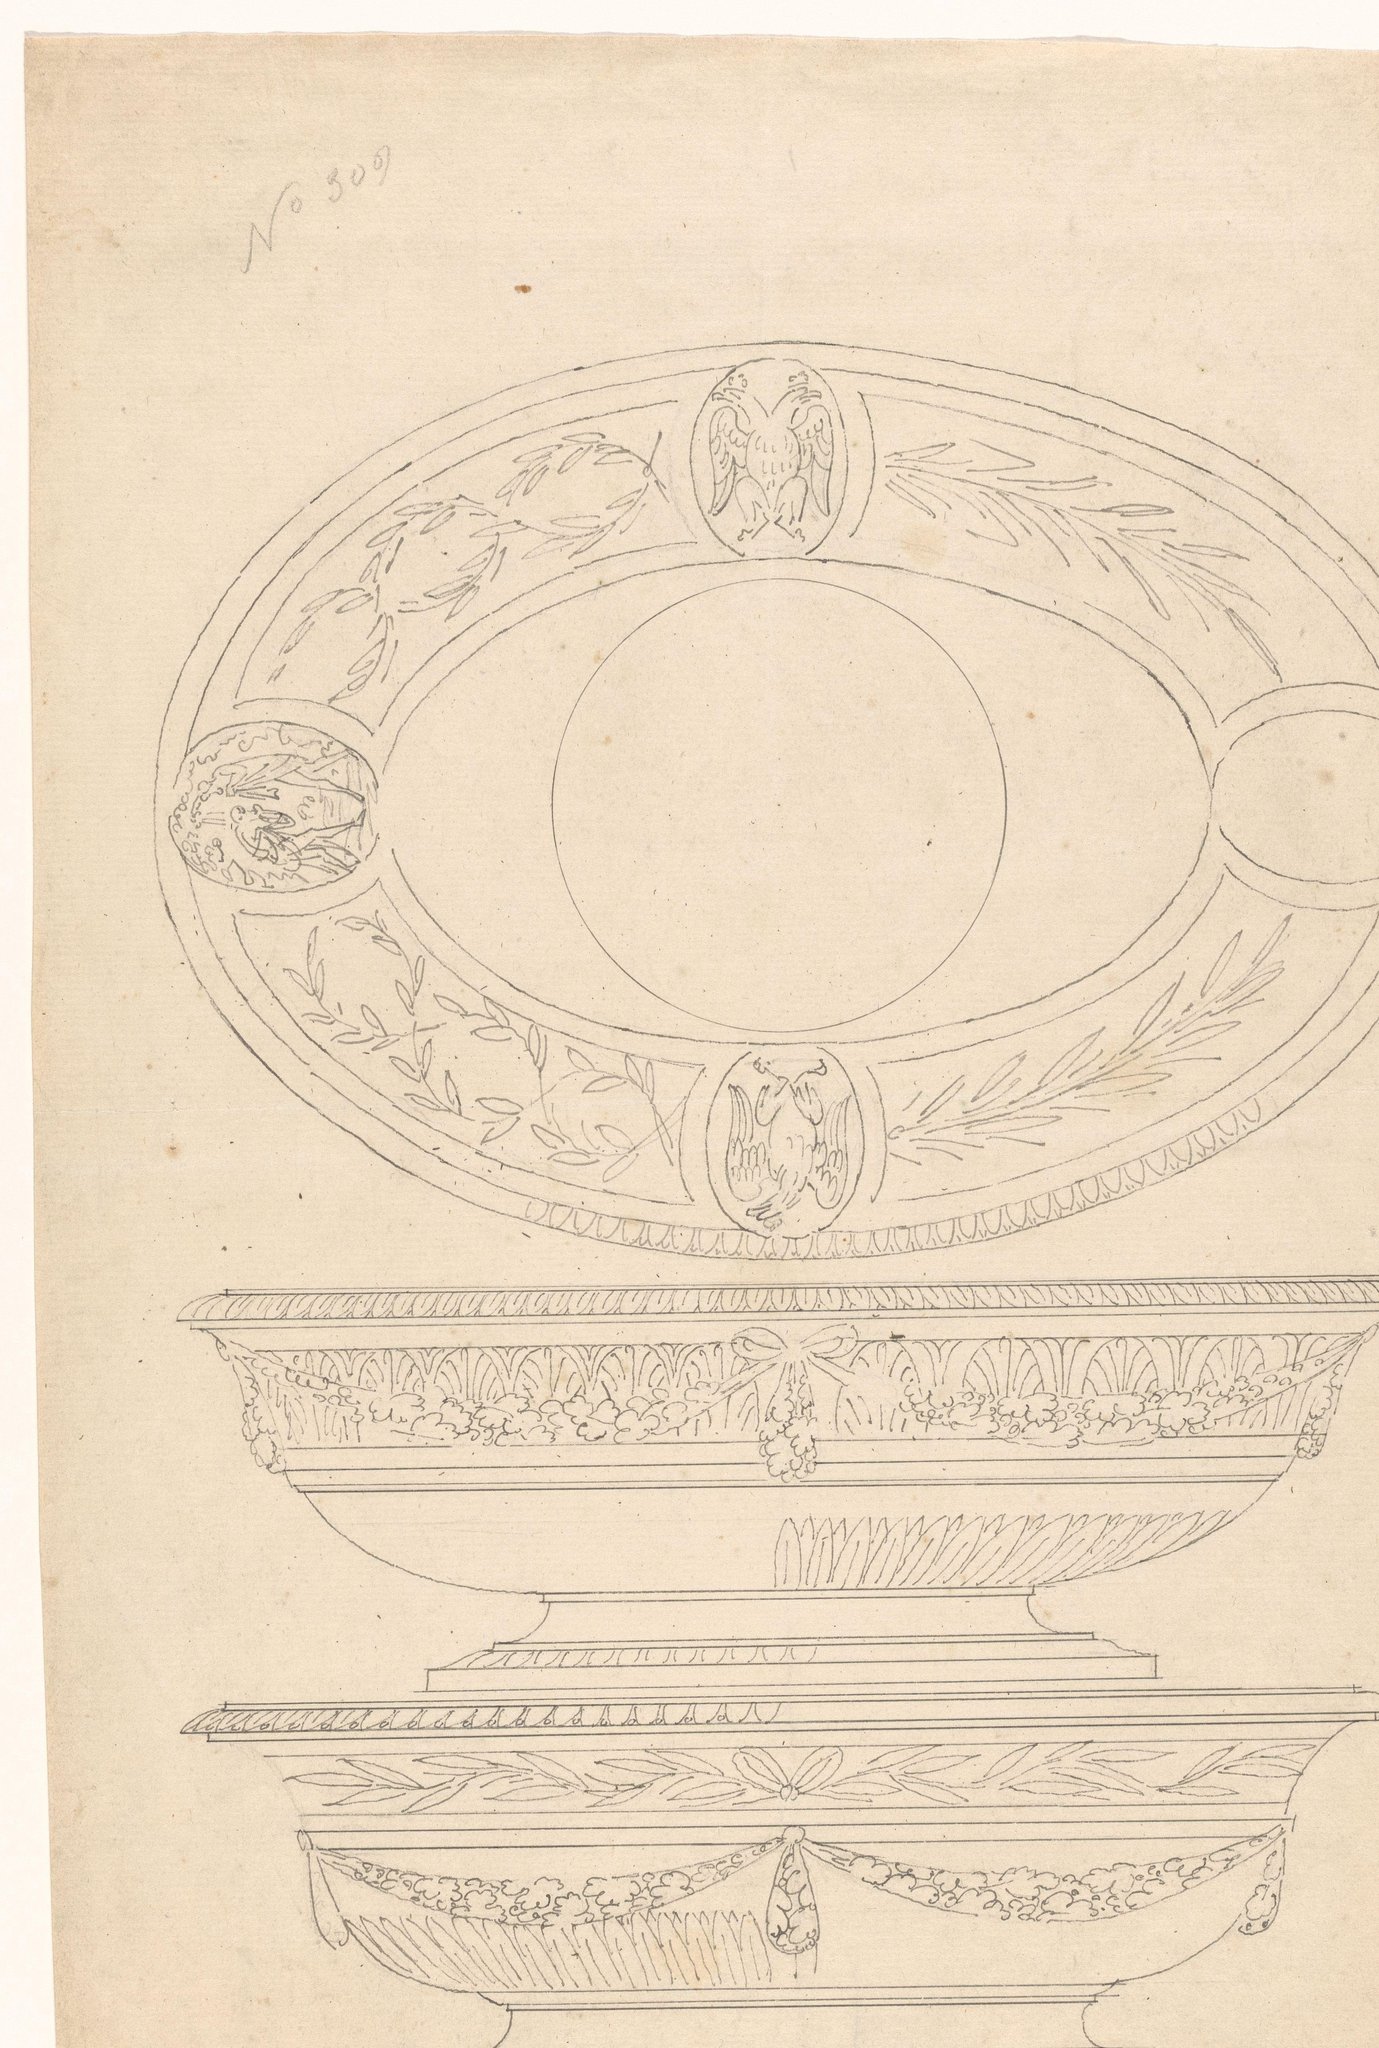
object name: design drawing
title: Ontwerp voor een doopvont, met een bovenaanzicht en twee varianten van een vooraanzicht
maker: Anonymous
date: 1810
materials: graphite, ink, paper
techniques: pen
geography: paris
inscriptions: number: ‘No 309’, watermark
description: Ontwerp voor hetzelfde bekken als op RP-T-2019-345, maar niet volledig weergegeven en minder uitgewerkt.